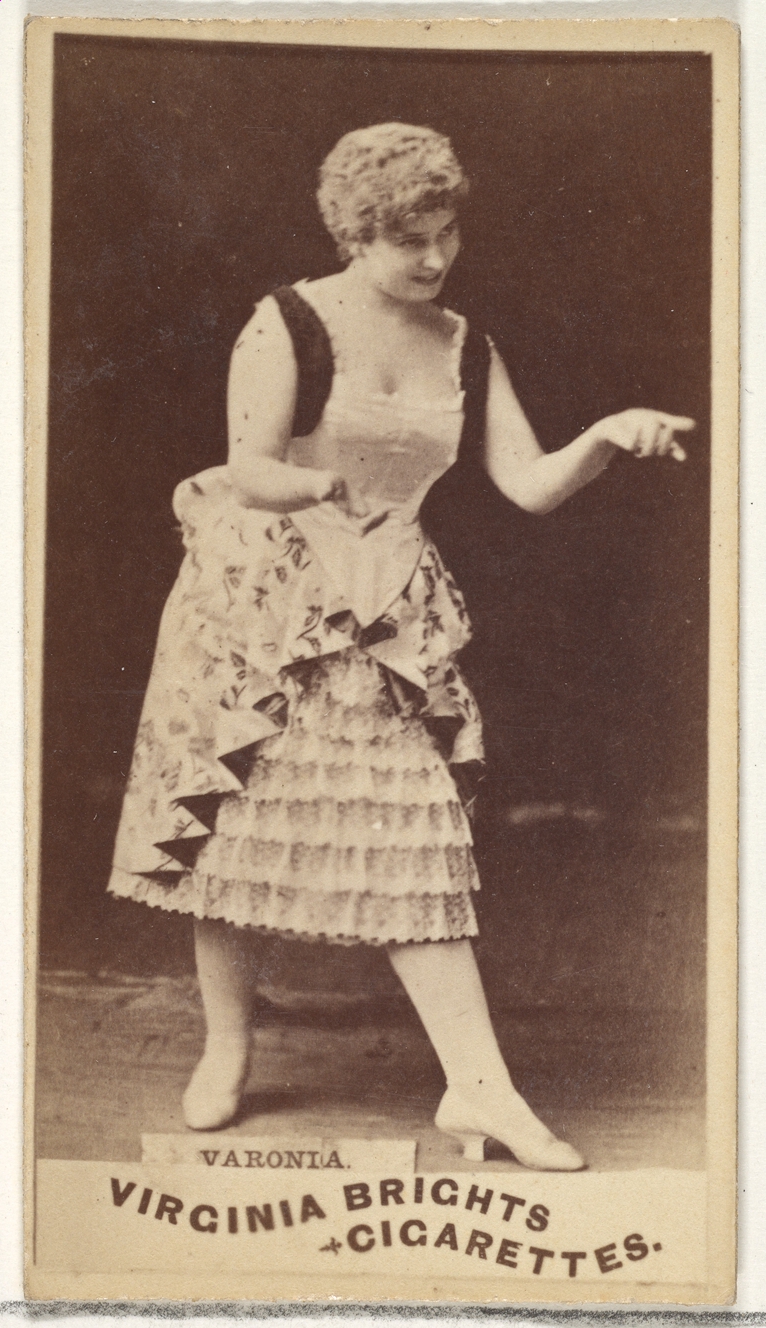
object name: photograph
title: Varonia, from the Actors and Actresses series (N45, Type 1) for Virginia Brights Cigarettes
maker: allen & ginter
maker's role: publisher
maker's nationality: american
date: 1888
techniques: albumen silver print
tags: portraits,women,actresses